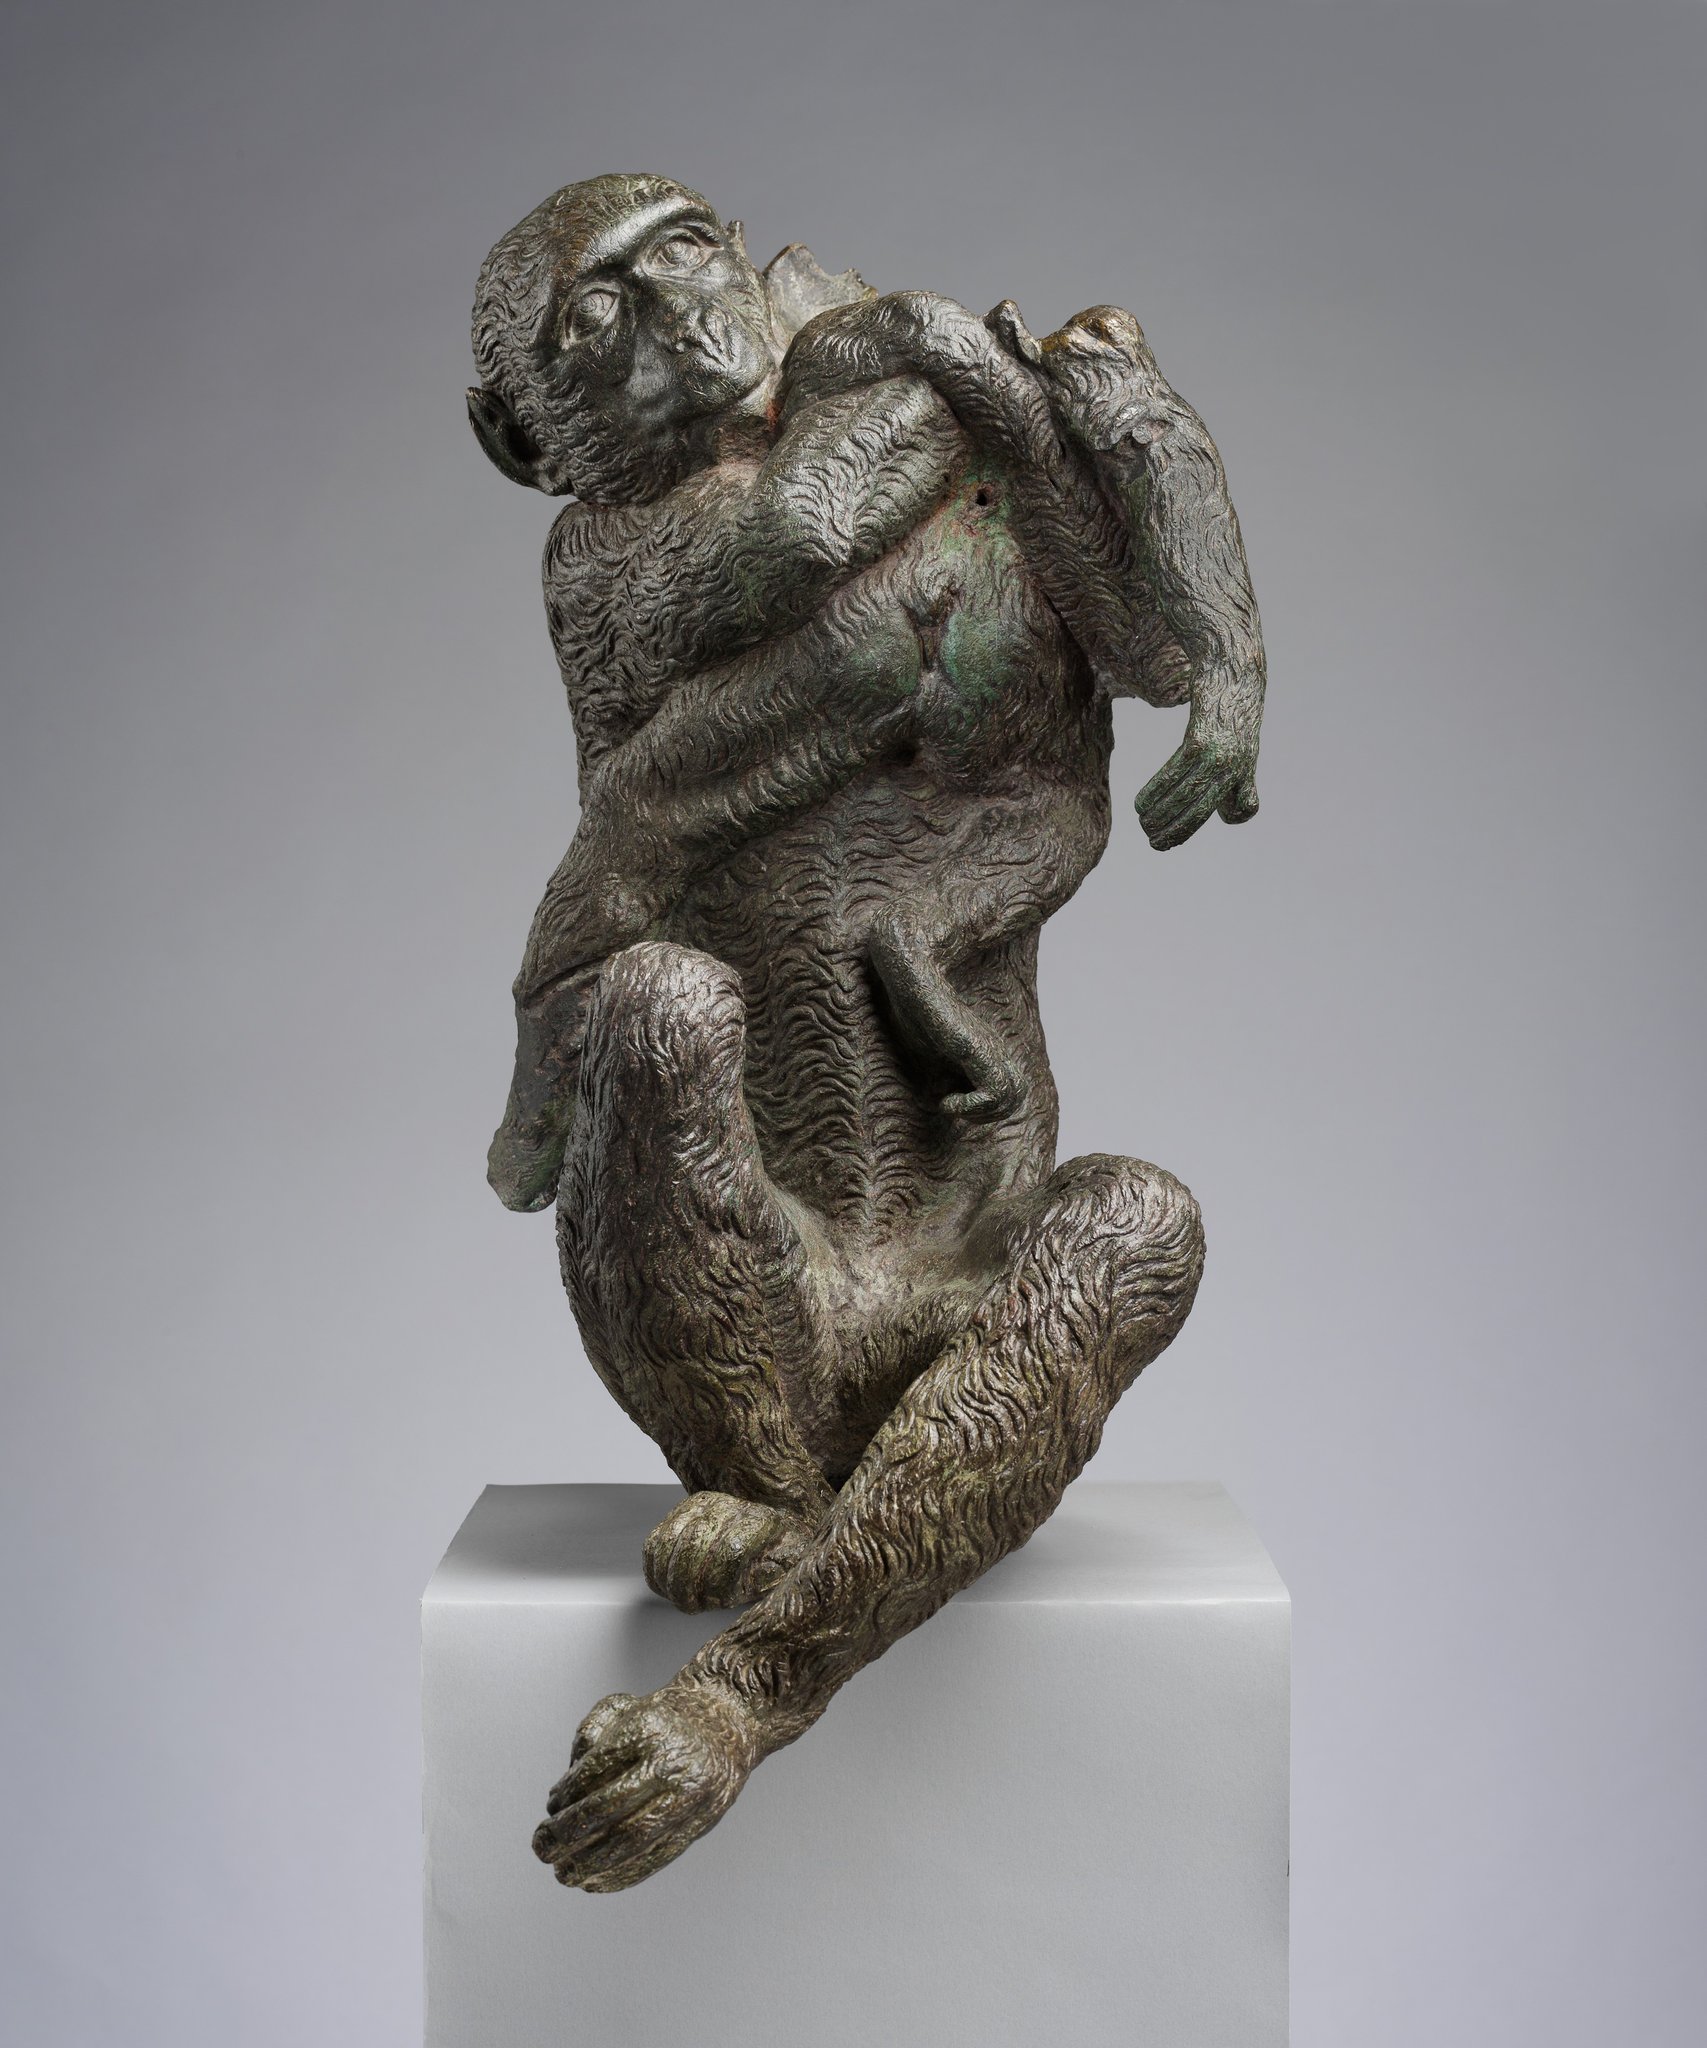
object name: statue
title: Mother ape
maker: camillo mariani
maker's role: maker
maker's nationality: italian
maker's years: 1567-1611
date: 1595-1596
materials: bronze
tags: monkeys